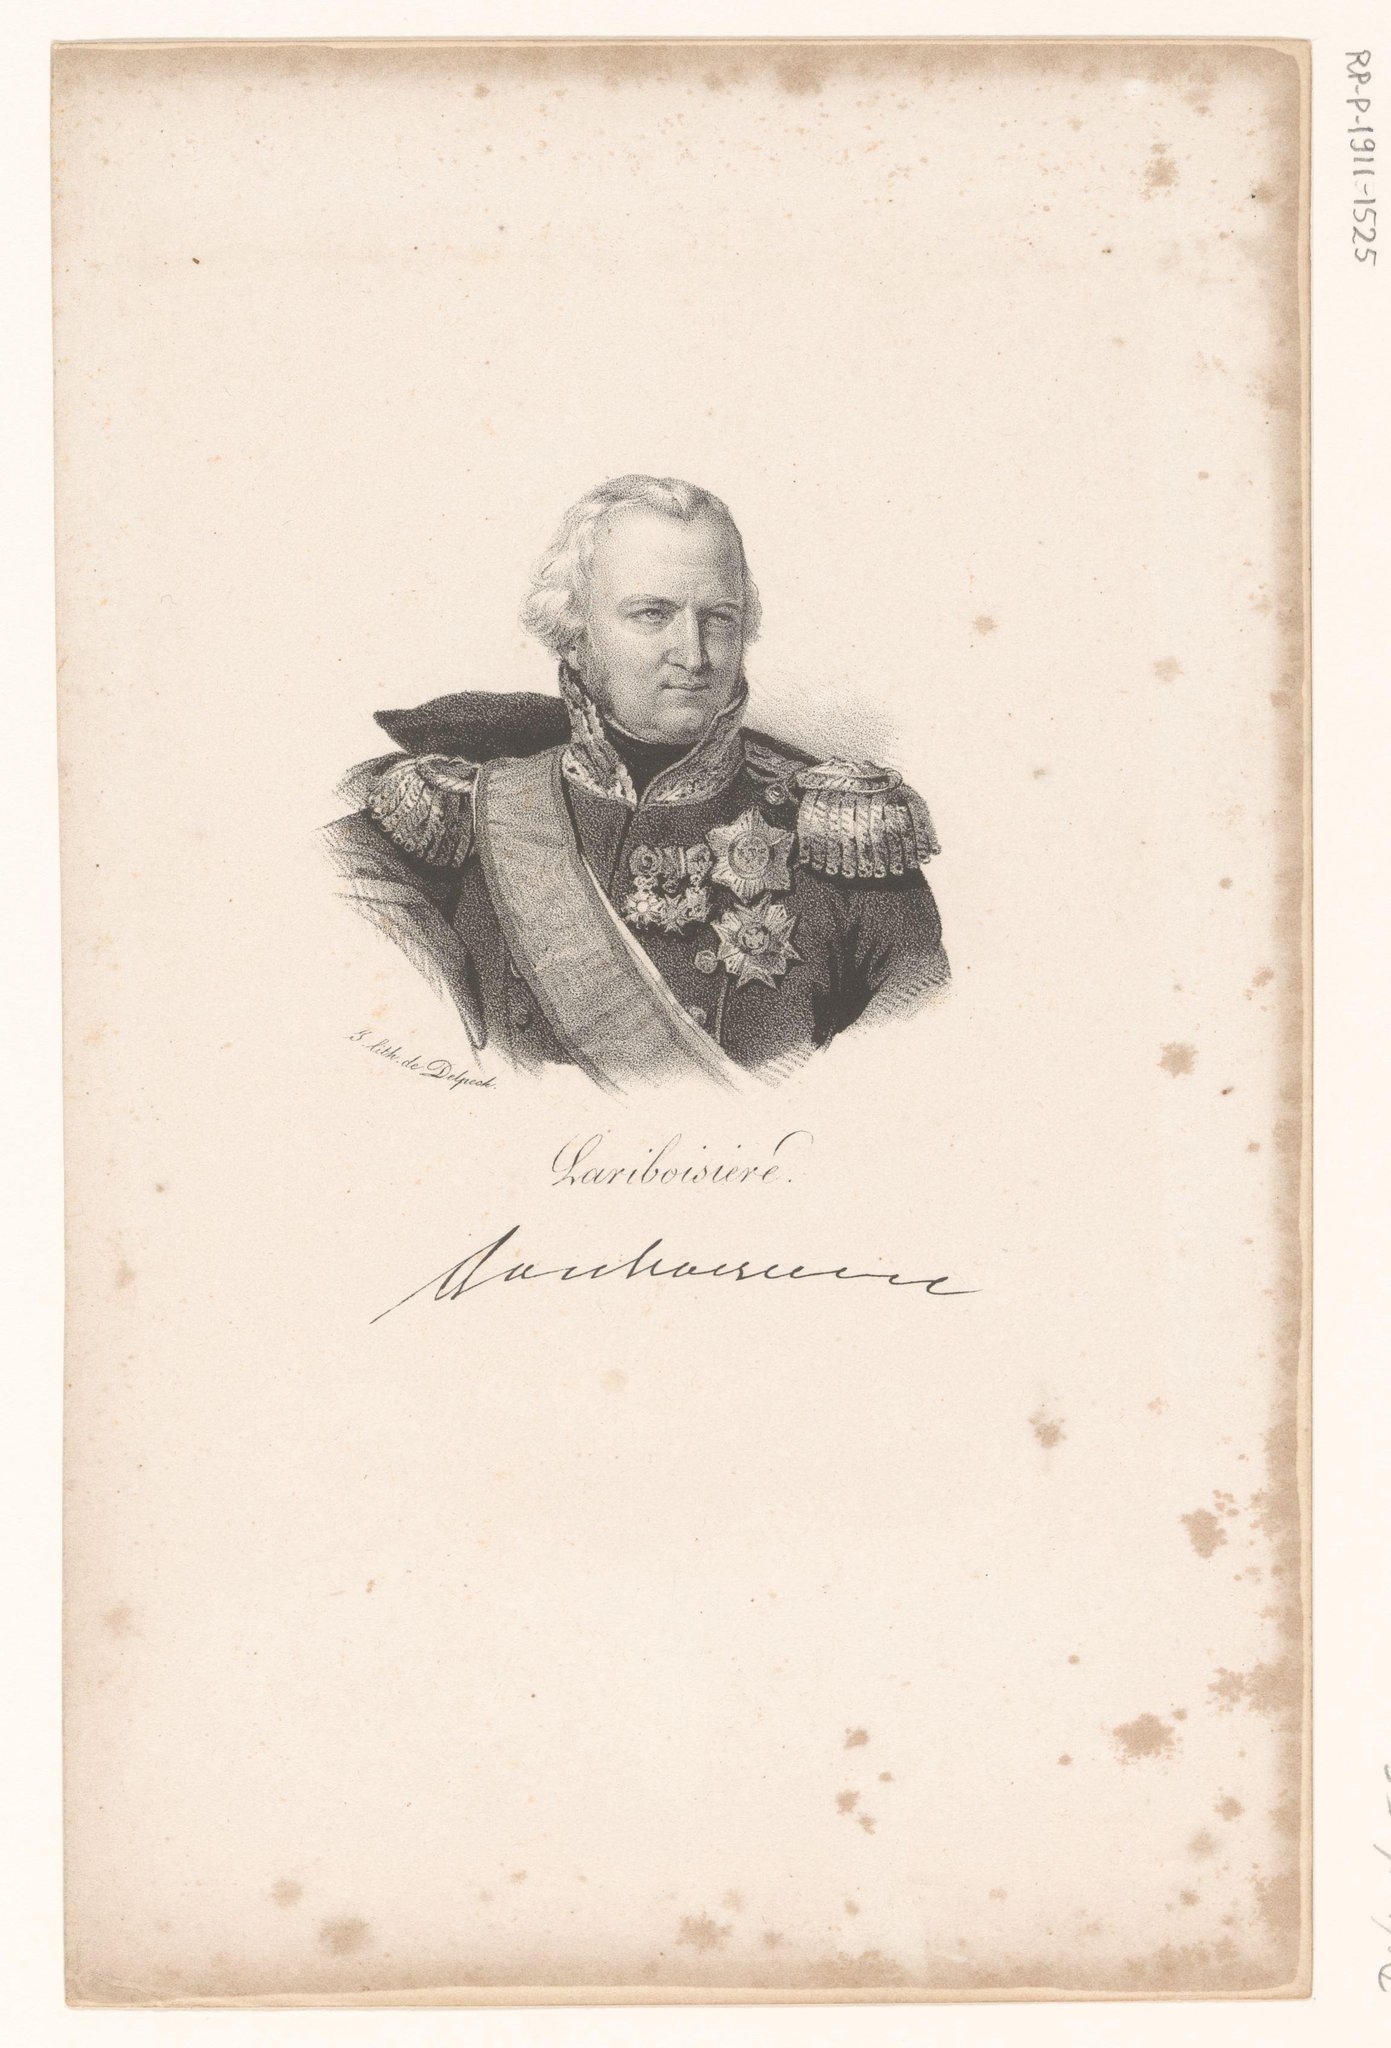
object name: print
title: Portret van Jean Ambroise Baston de Lariboisière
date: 1818-1842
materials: paper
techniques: lithograph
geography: paris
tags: historical persons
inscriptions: collector's mark: Lugt 2228a